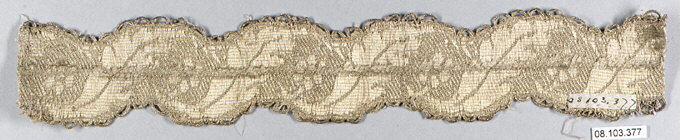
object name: galloon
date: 1601-1800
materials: metal thread